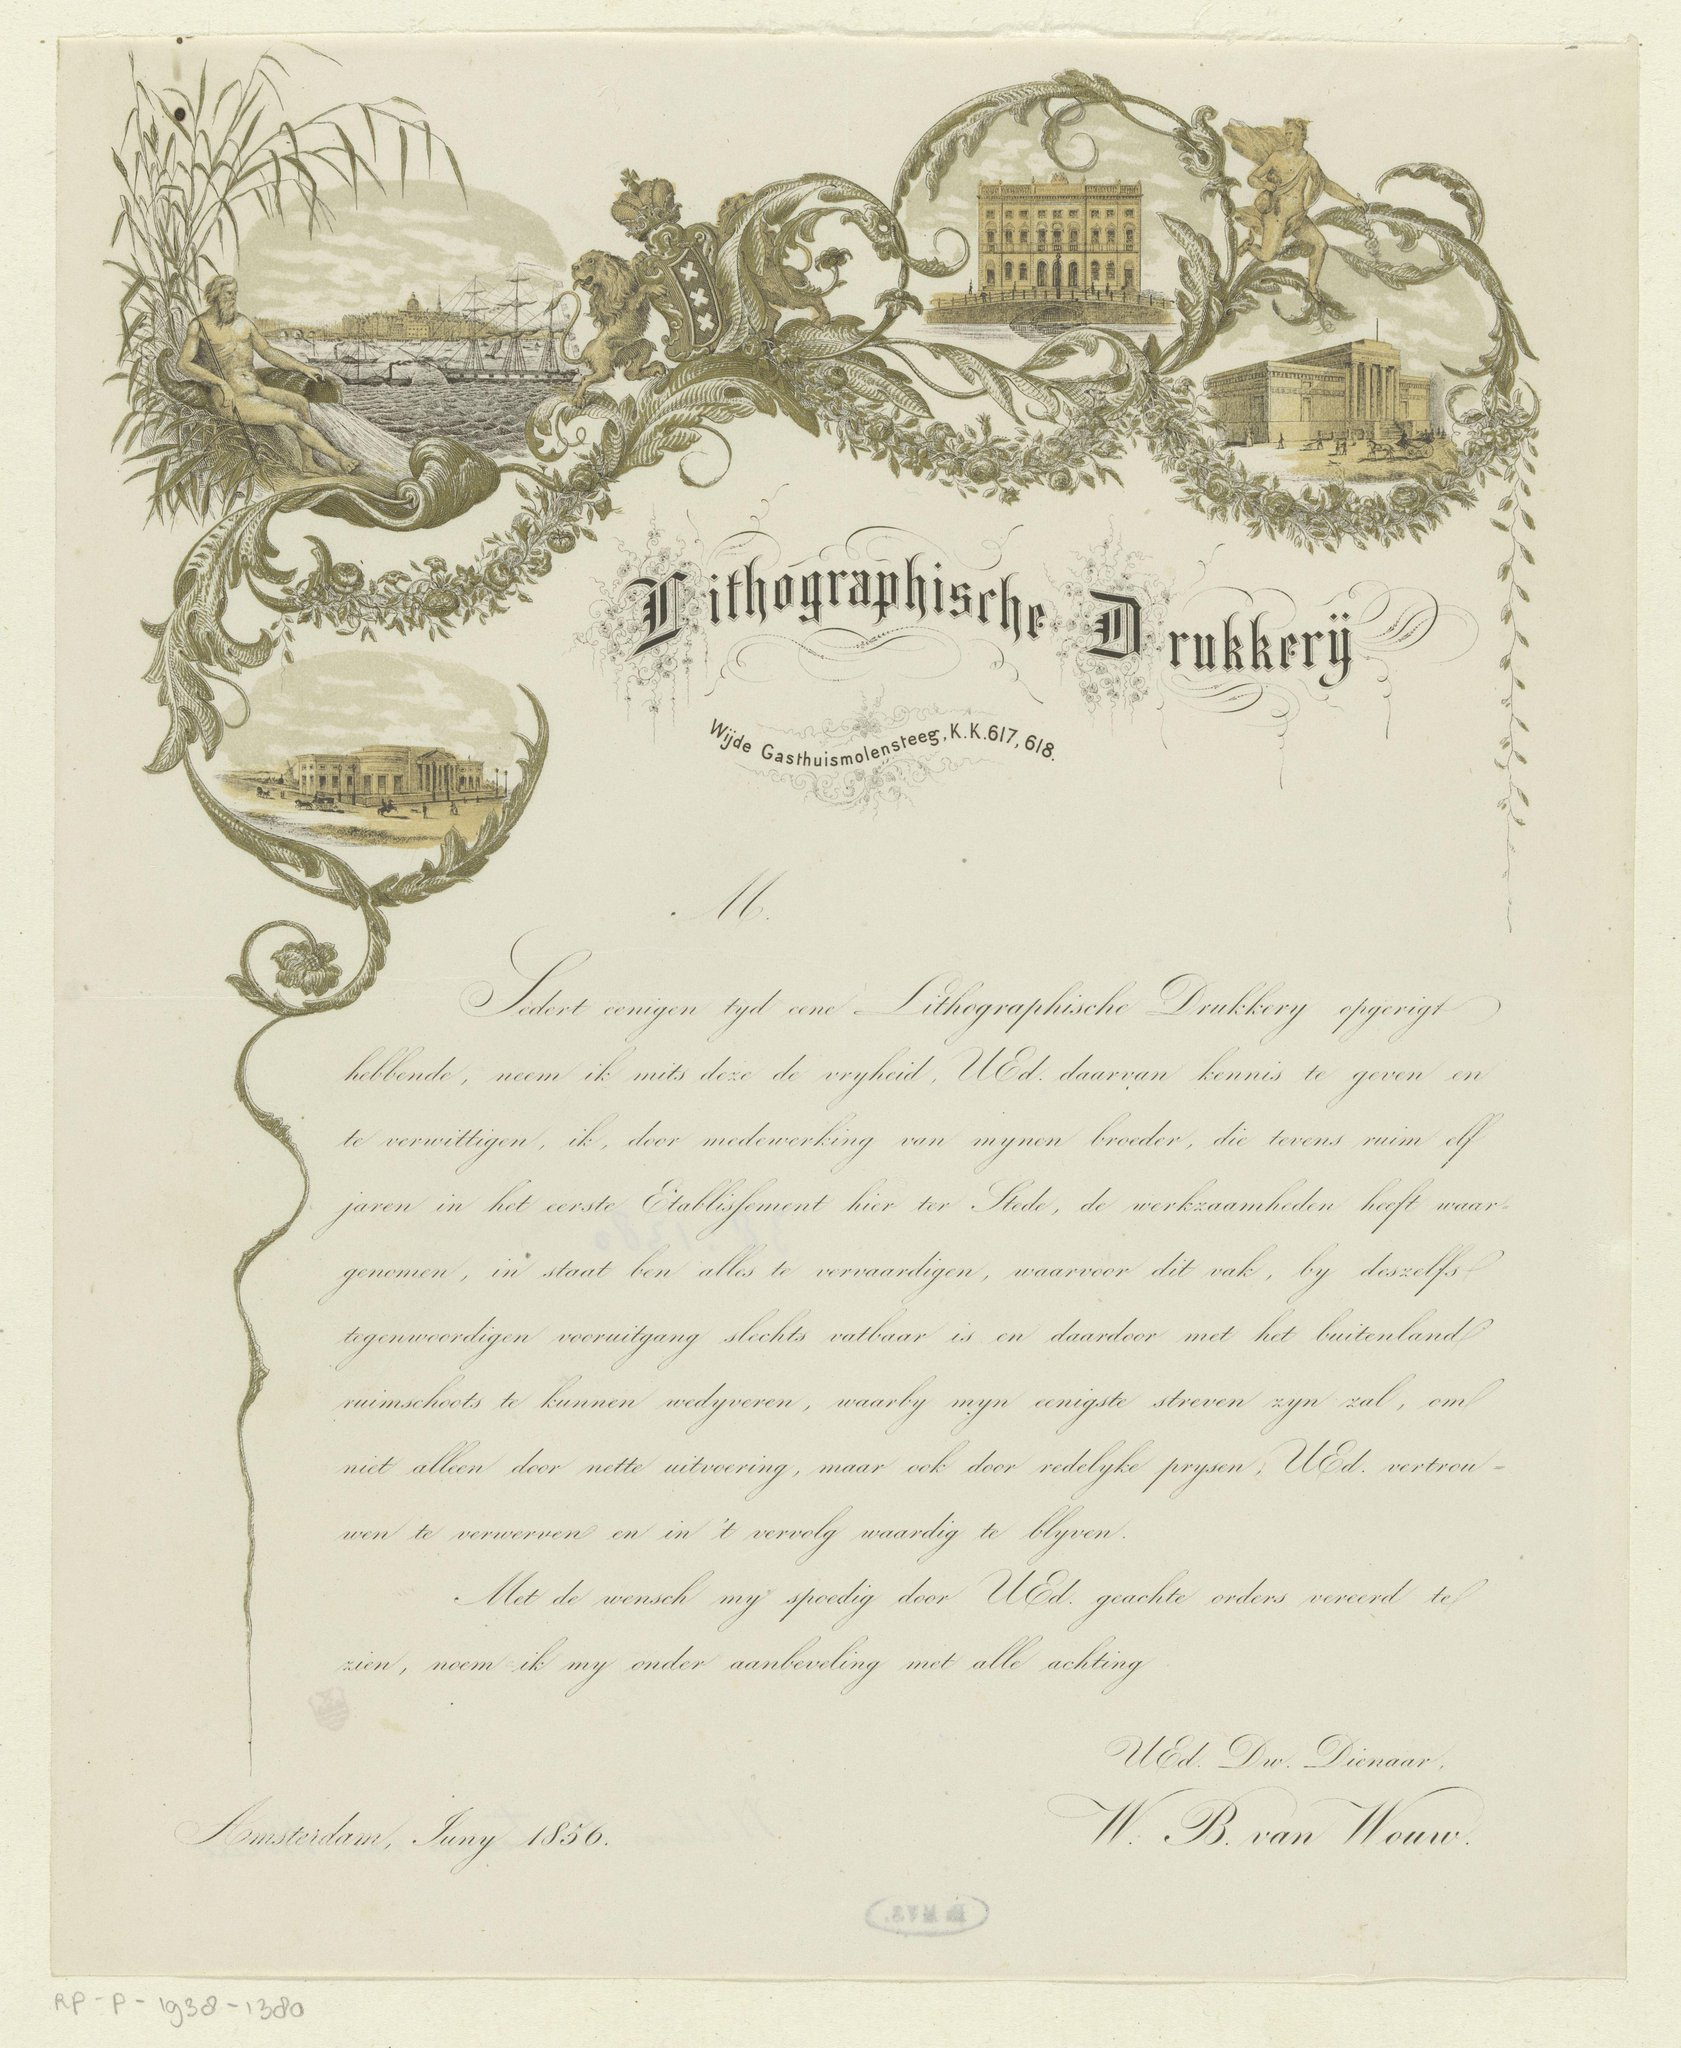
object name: print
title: Aankondigingsblad met randvignetten voor de lithografische drukkerij van W.B. van Wouw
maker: willem bastiaan van wouw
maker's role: print maker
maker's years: 1822-1878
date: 1856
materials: paper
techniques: chromolithography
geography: amsterdam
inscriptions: collector's mark: Lugt 2228, collector's mark: Lugt 2760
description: Afgebeeld zijn gezichten op Amsterdam waaronder de beurs van Zocher, een riviergod en de stad Amsterdam. Daaronder een tekst waarin Willem Bastiaan van Wouw zichzelf voorstelt en aanbeveelt als steendrukker.